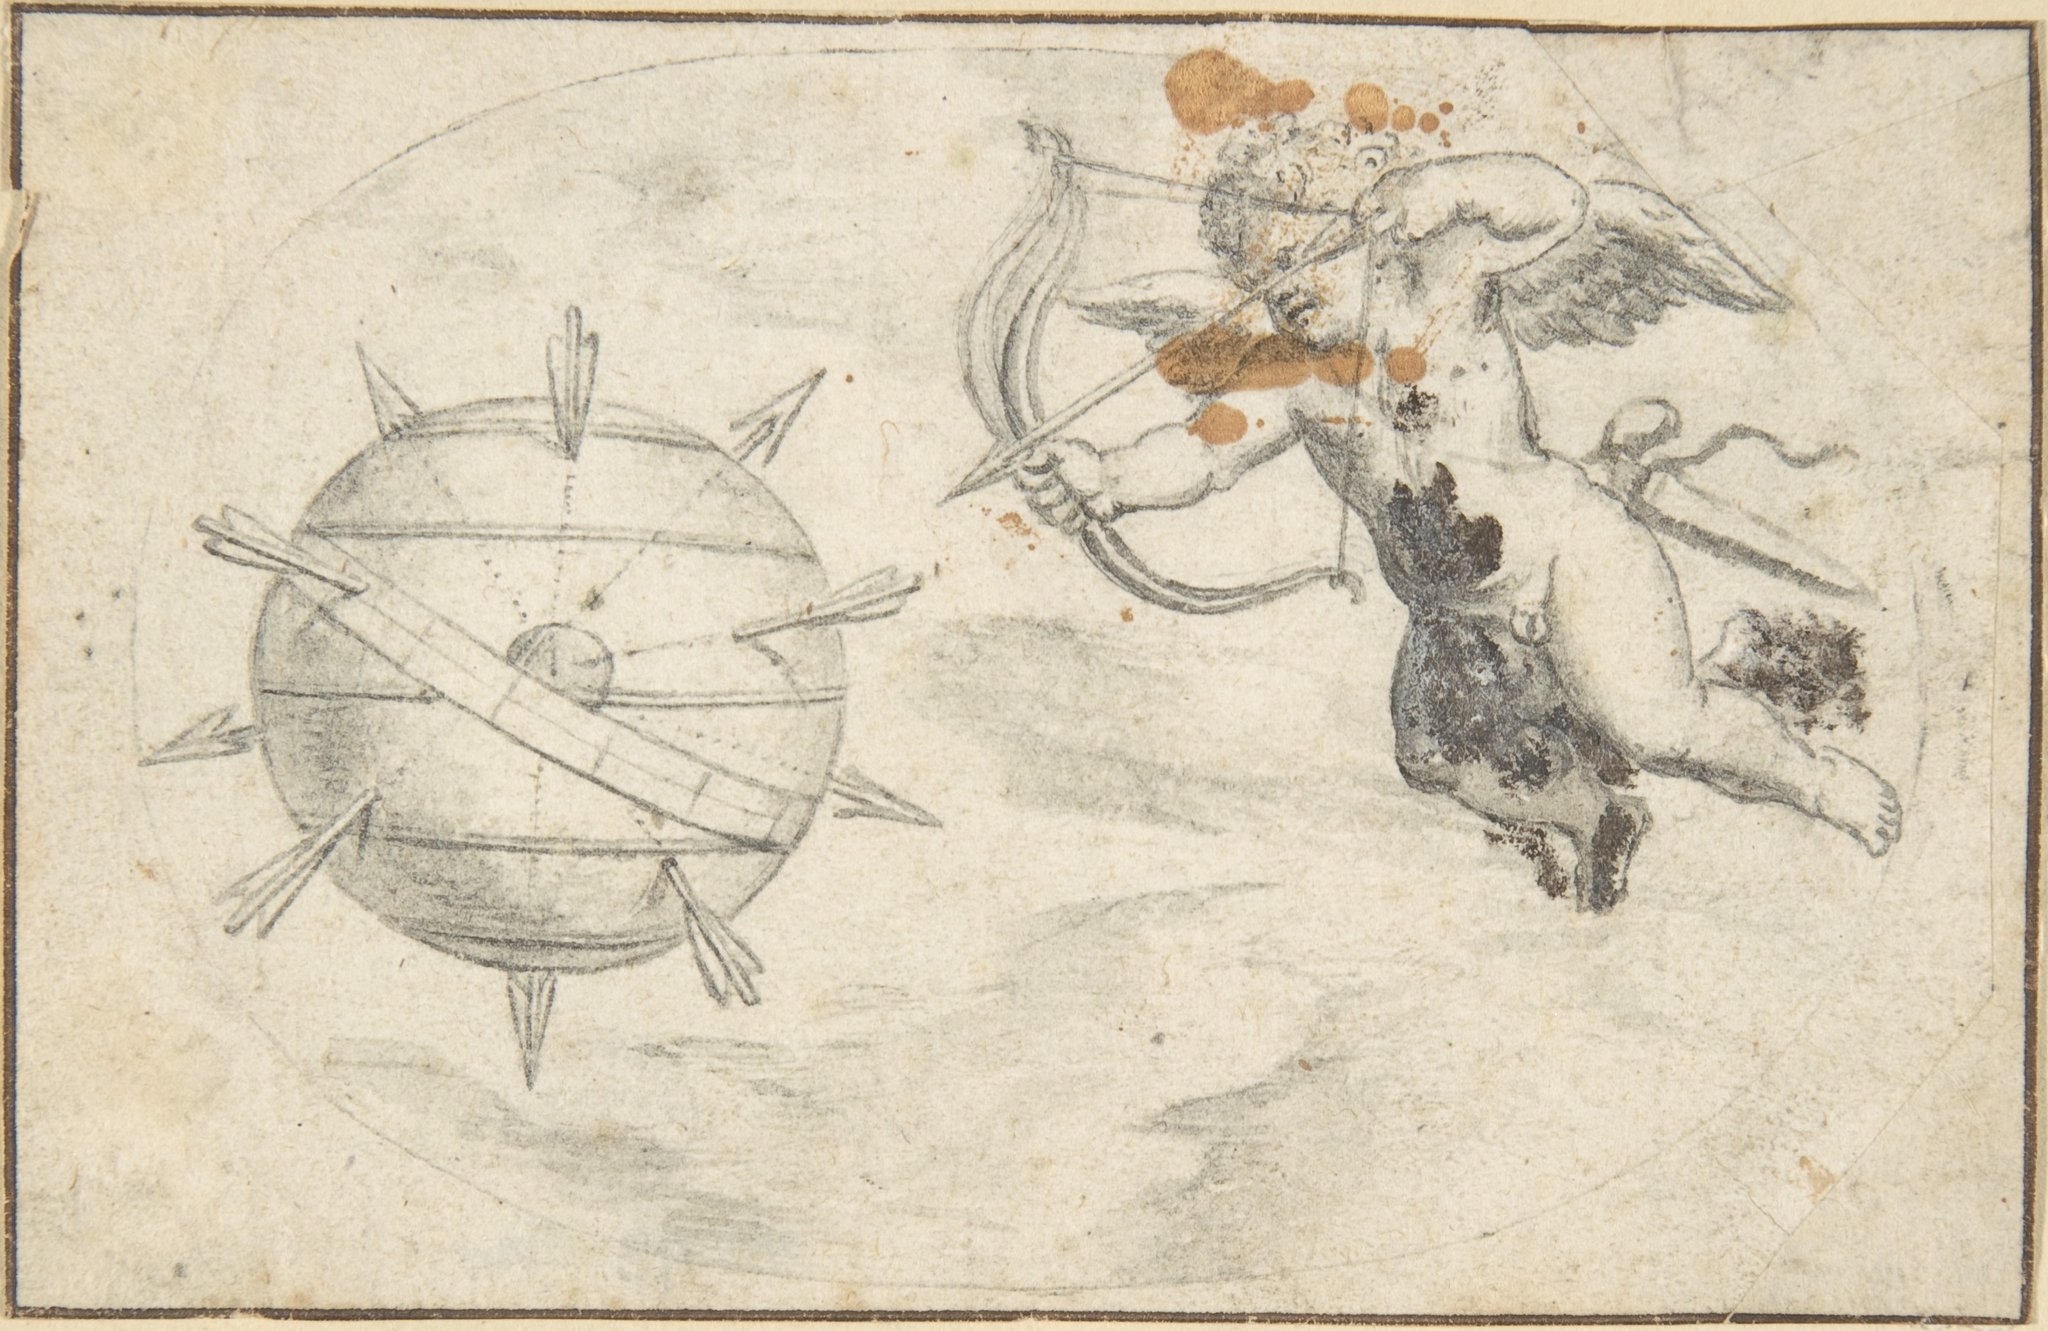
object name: drawing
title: Cupid Shooting Arrows at the World Globe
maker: otto van veen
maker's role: artist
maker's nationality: netherlandish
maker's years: 1556-1629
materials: chalk, gouache, ink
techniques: brush, incising, pen, transfer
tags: bow and arrow,cupid,globes